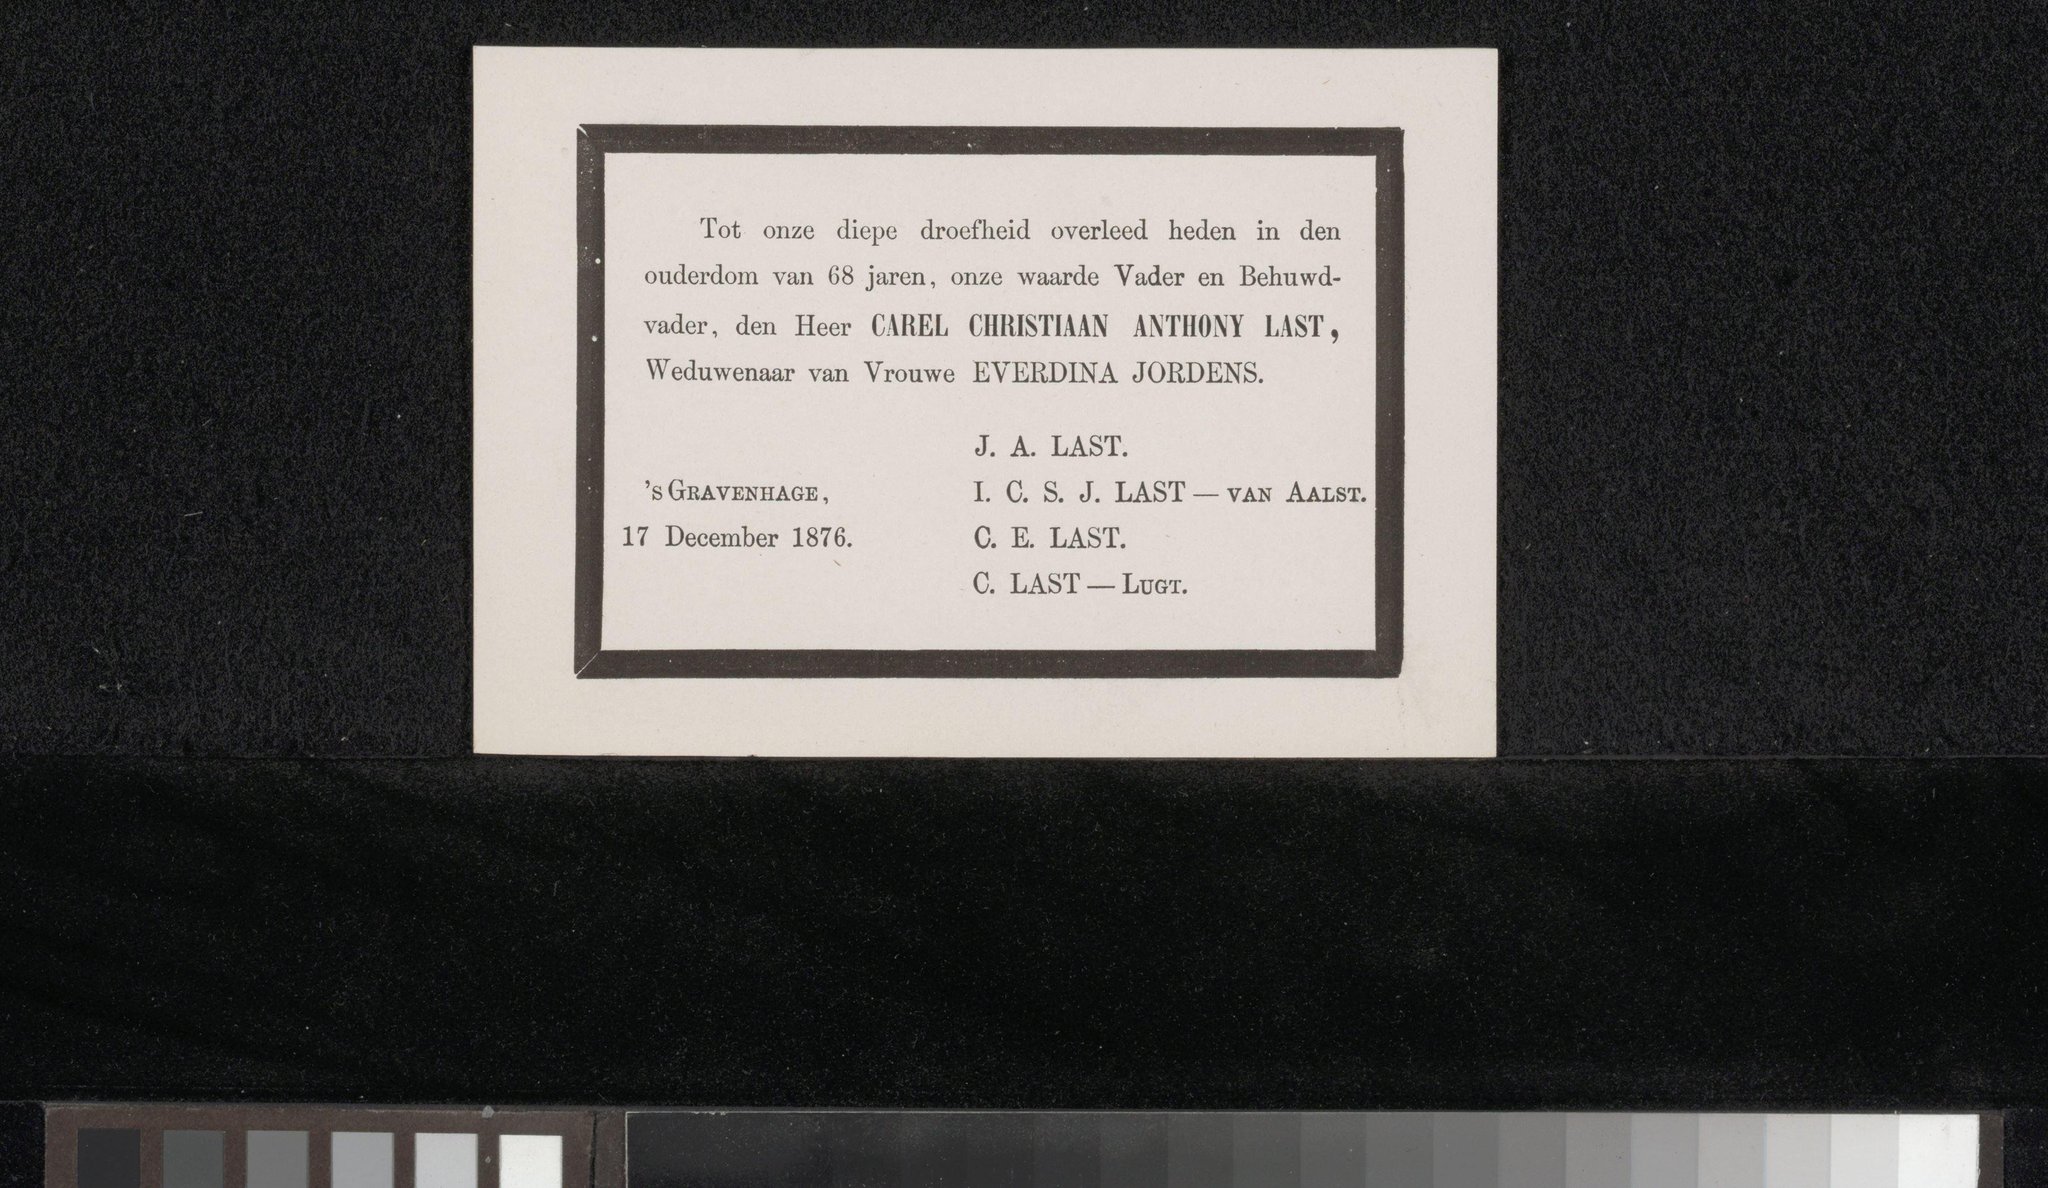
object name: overlijdensbericht, overlijdensadvertentie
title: Overlijdensbericht betreffende Carel Christiaan Antony Last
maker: Anonymous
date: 1876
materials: cardboard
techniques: printing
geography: the hague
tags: amsterdam, print maker, carel christiaan antony last